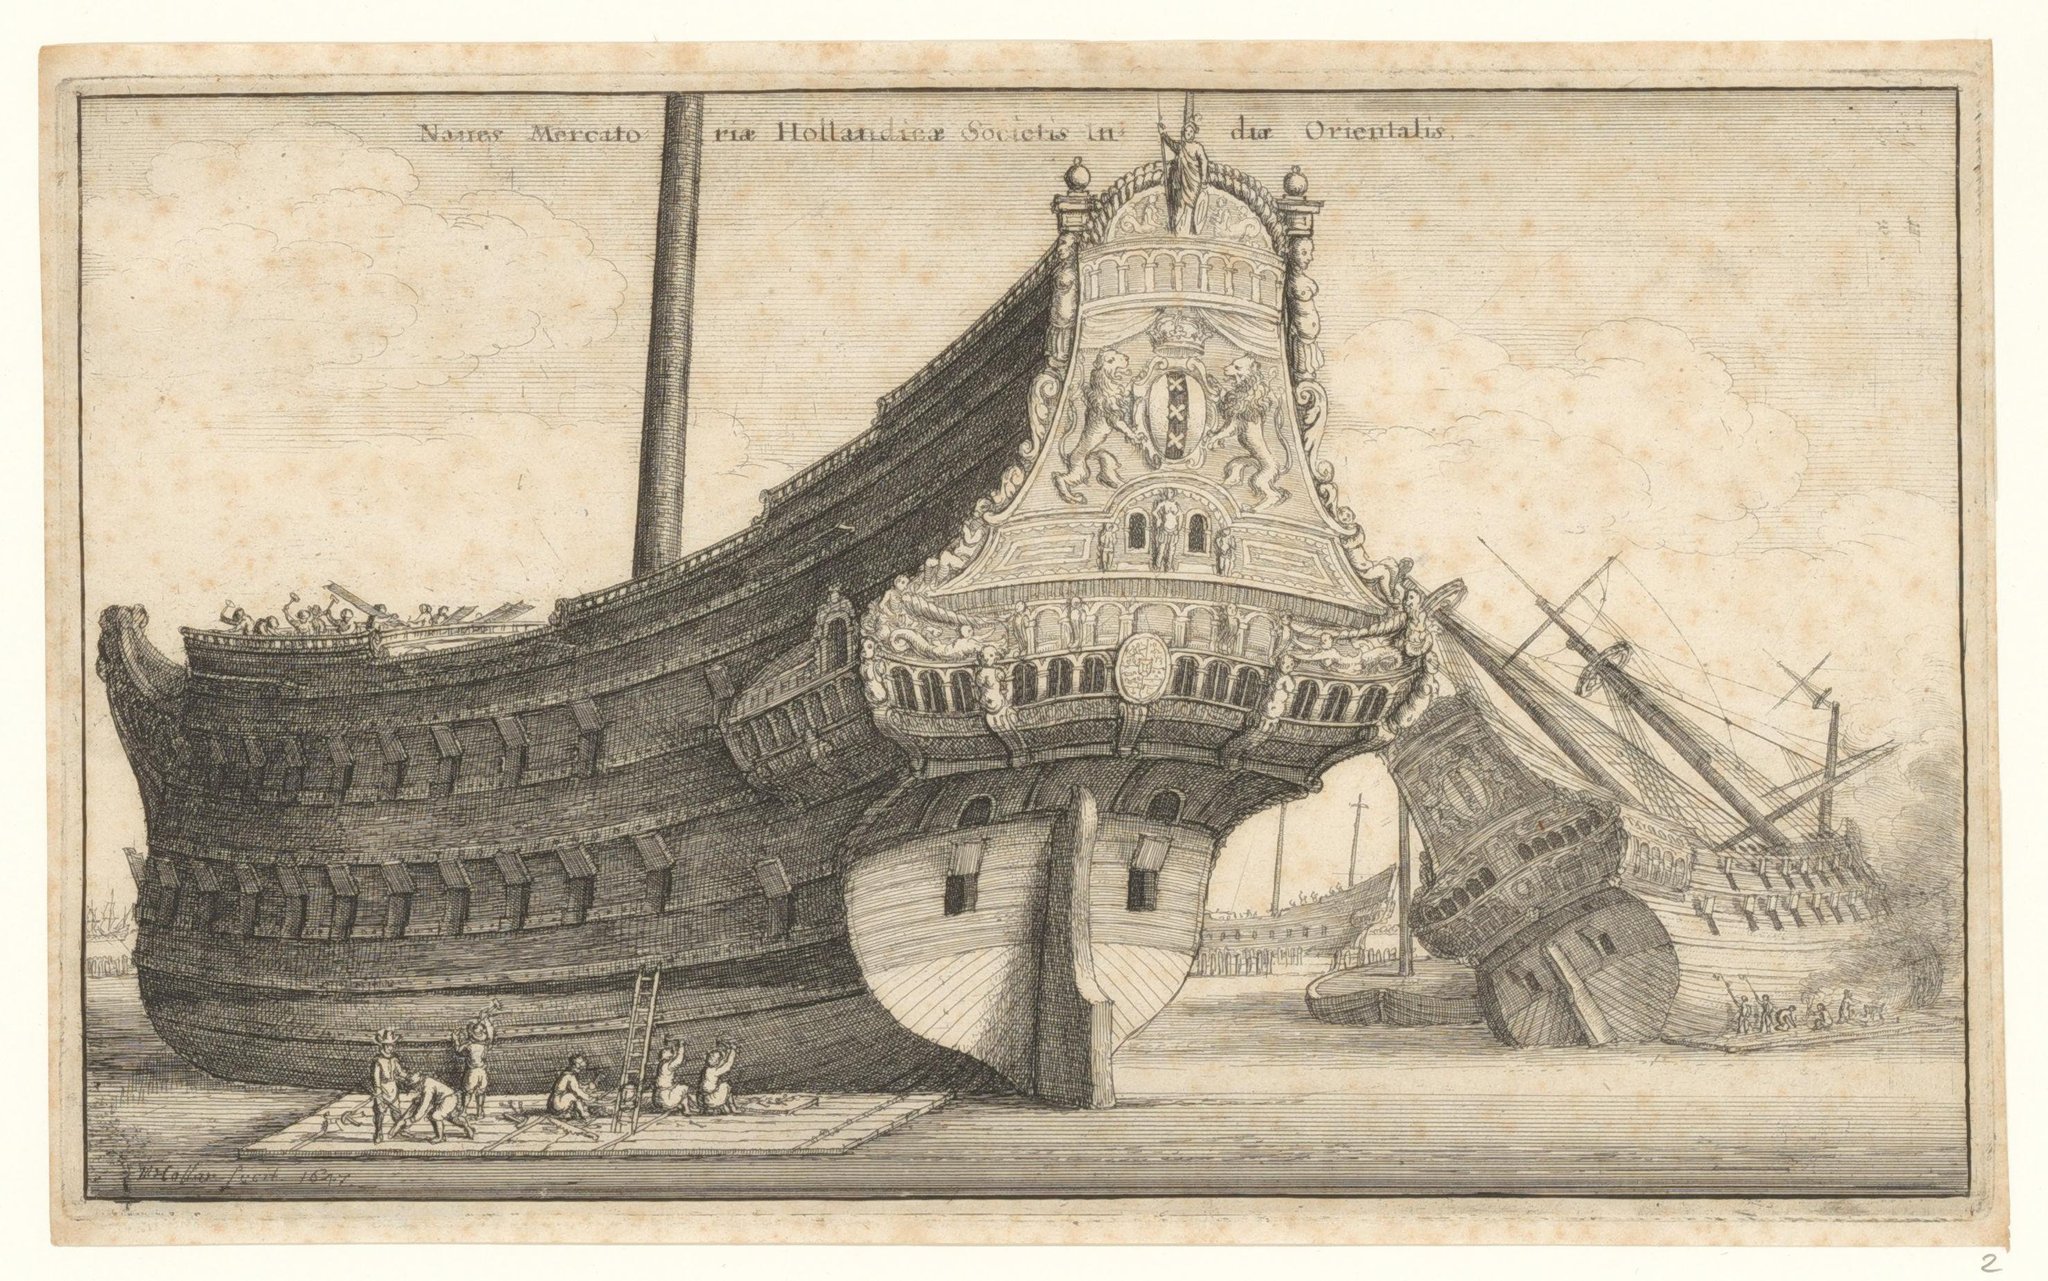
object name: print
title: Naves Mercatoriae Hollandicae Societis Indiae Orientalis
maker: wenceslaus hollar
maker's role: draughtsman, print maker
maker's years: 1607-1677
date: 1647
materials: paper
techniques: etching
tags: building a ship, ship under construction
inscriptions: collector's mark: Lugt 1641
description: Onderwerpsrubrieken binnen de Atlas Zeden en Gewoonten: Handel, Nijverheid en Verkeer, Scheepsbouw.